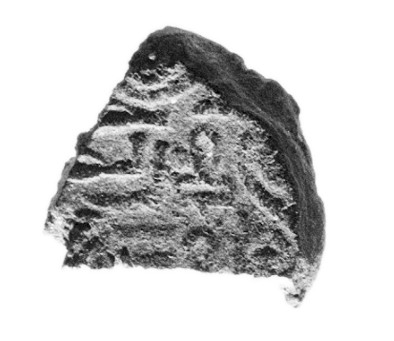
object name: sealing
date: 1981-1640 BCE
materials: mud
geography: egypt